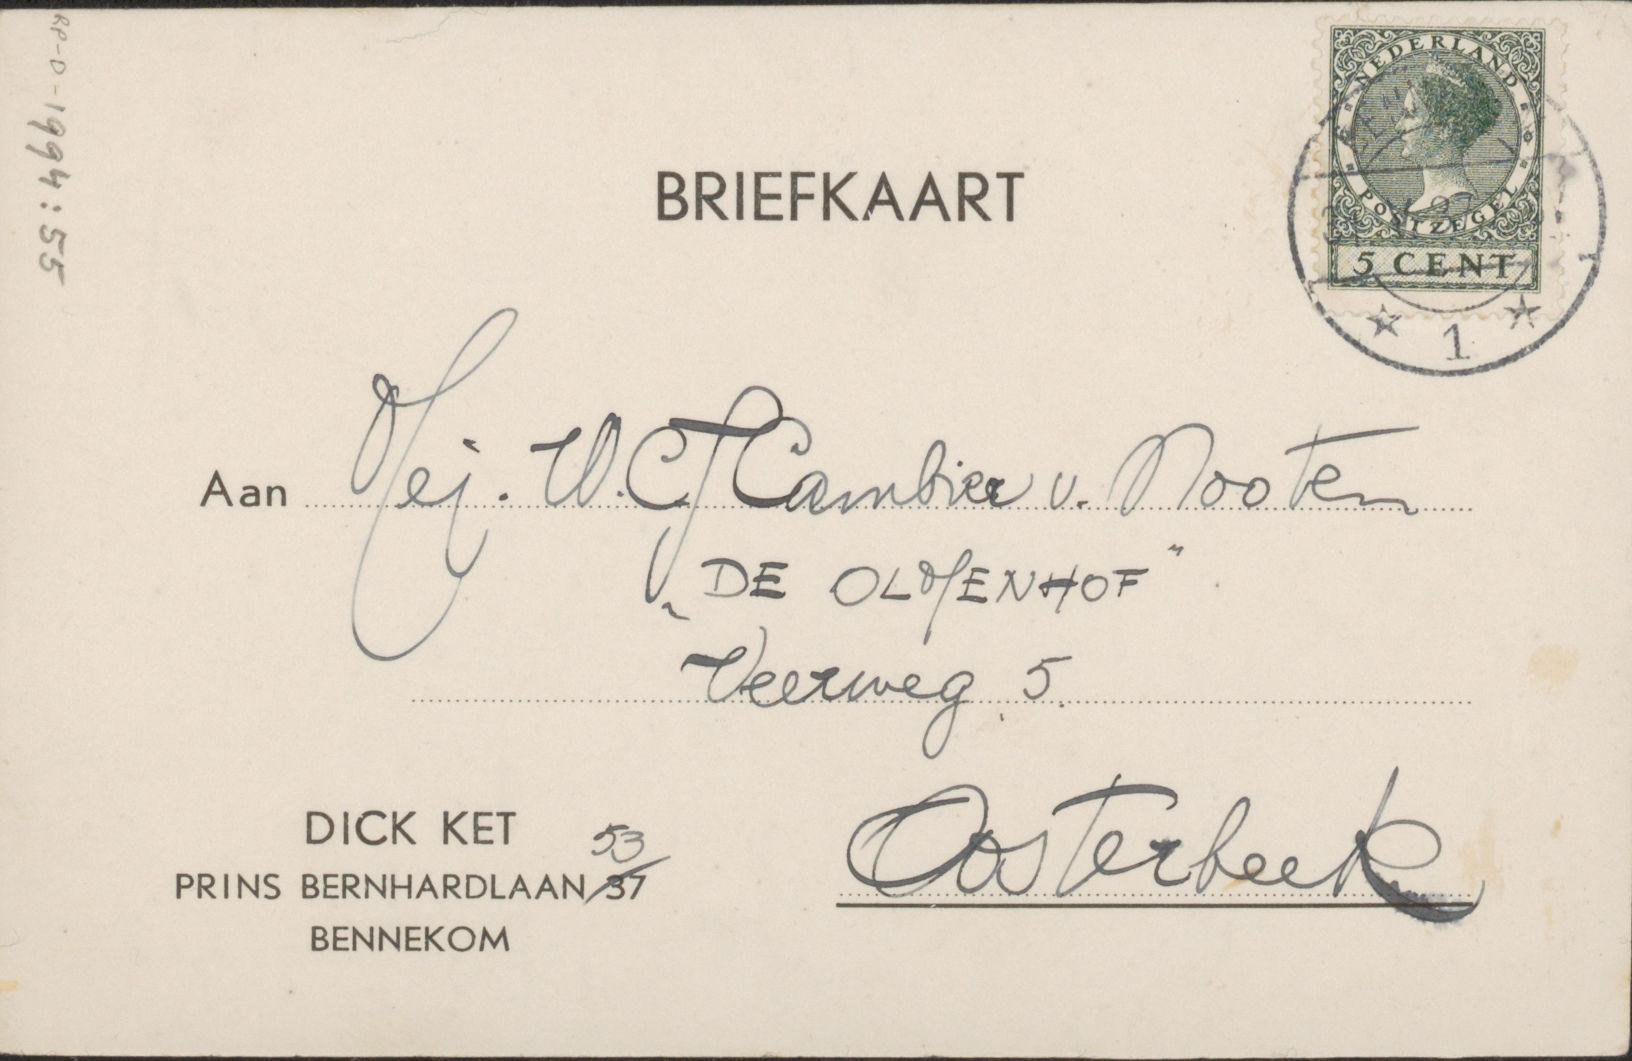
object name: postcard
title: Briefkaart aan Mien Cambier van Nooten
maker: dick ket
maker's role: draughtsman, print maker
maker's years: 1902-1940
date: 1937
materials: cardboard, ink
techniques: pen, writing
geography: bennekom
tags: arnhem, mien cambier van nooten